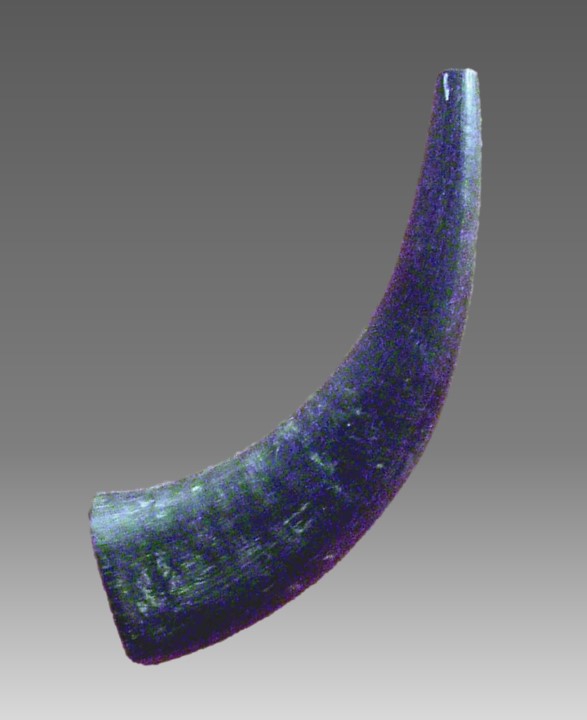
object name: gweh horn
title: Horn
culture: burmese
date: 1867-1900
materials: horn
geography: myanmar